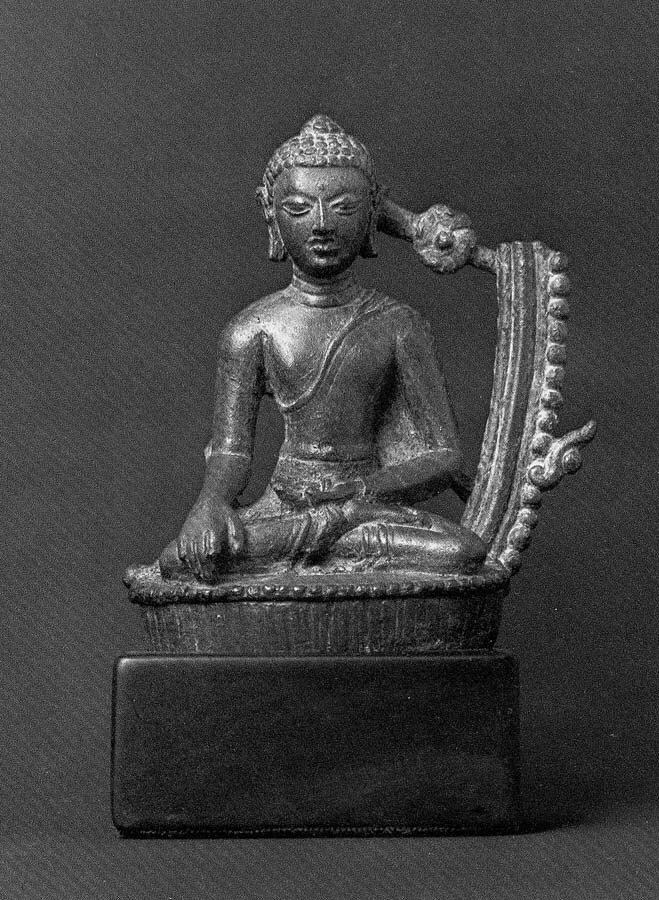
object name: figurine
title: Seated Buddha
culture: indian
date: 767-833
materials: bronze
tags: buddhism,buddha